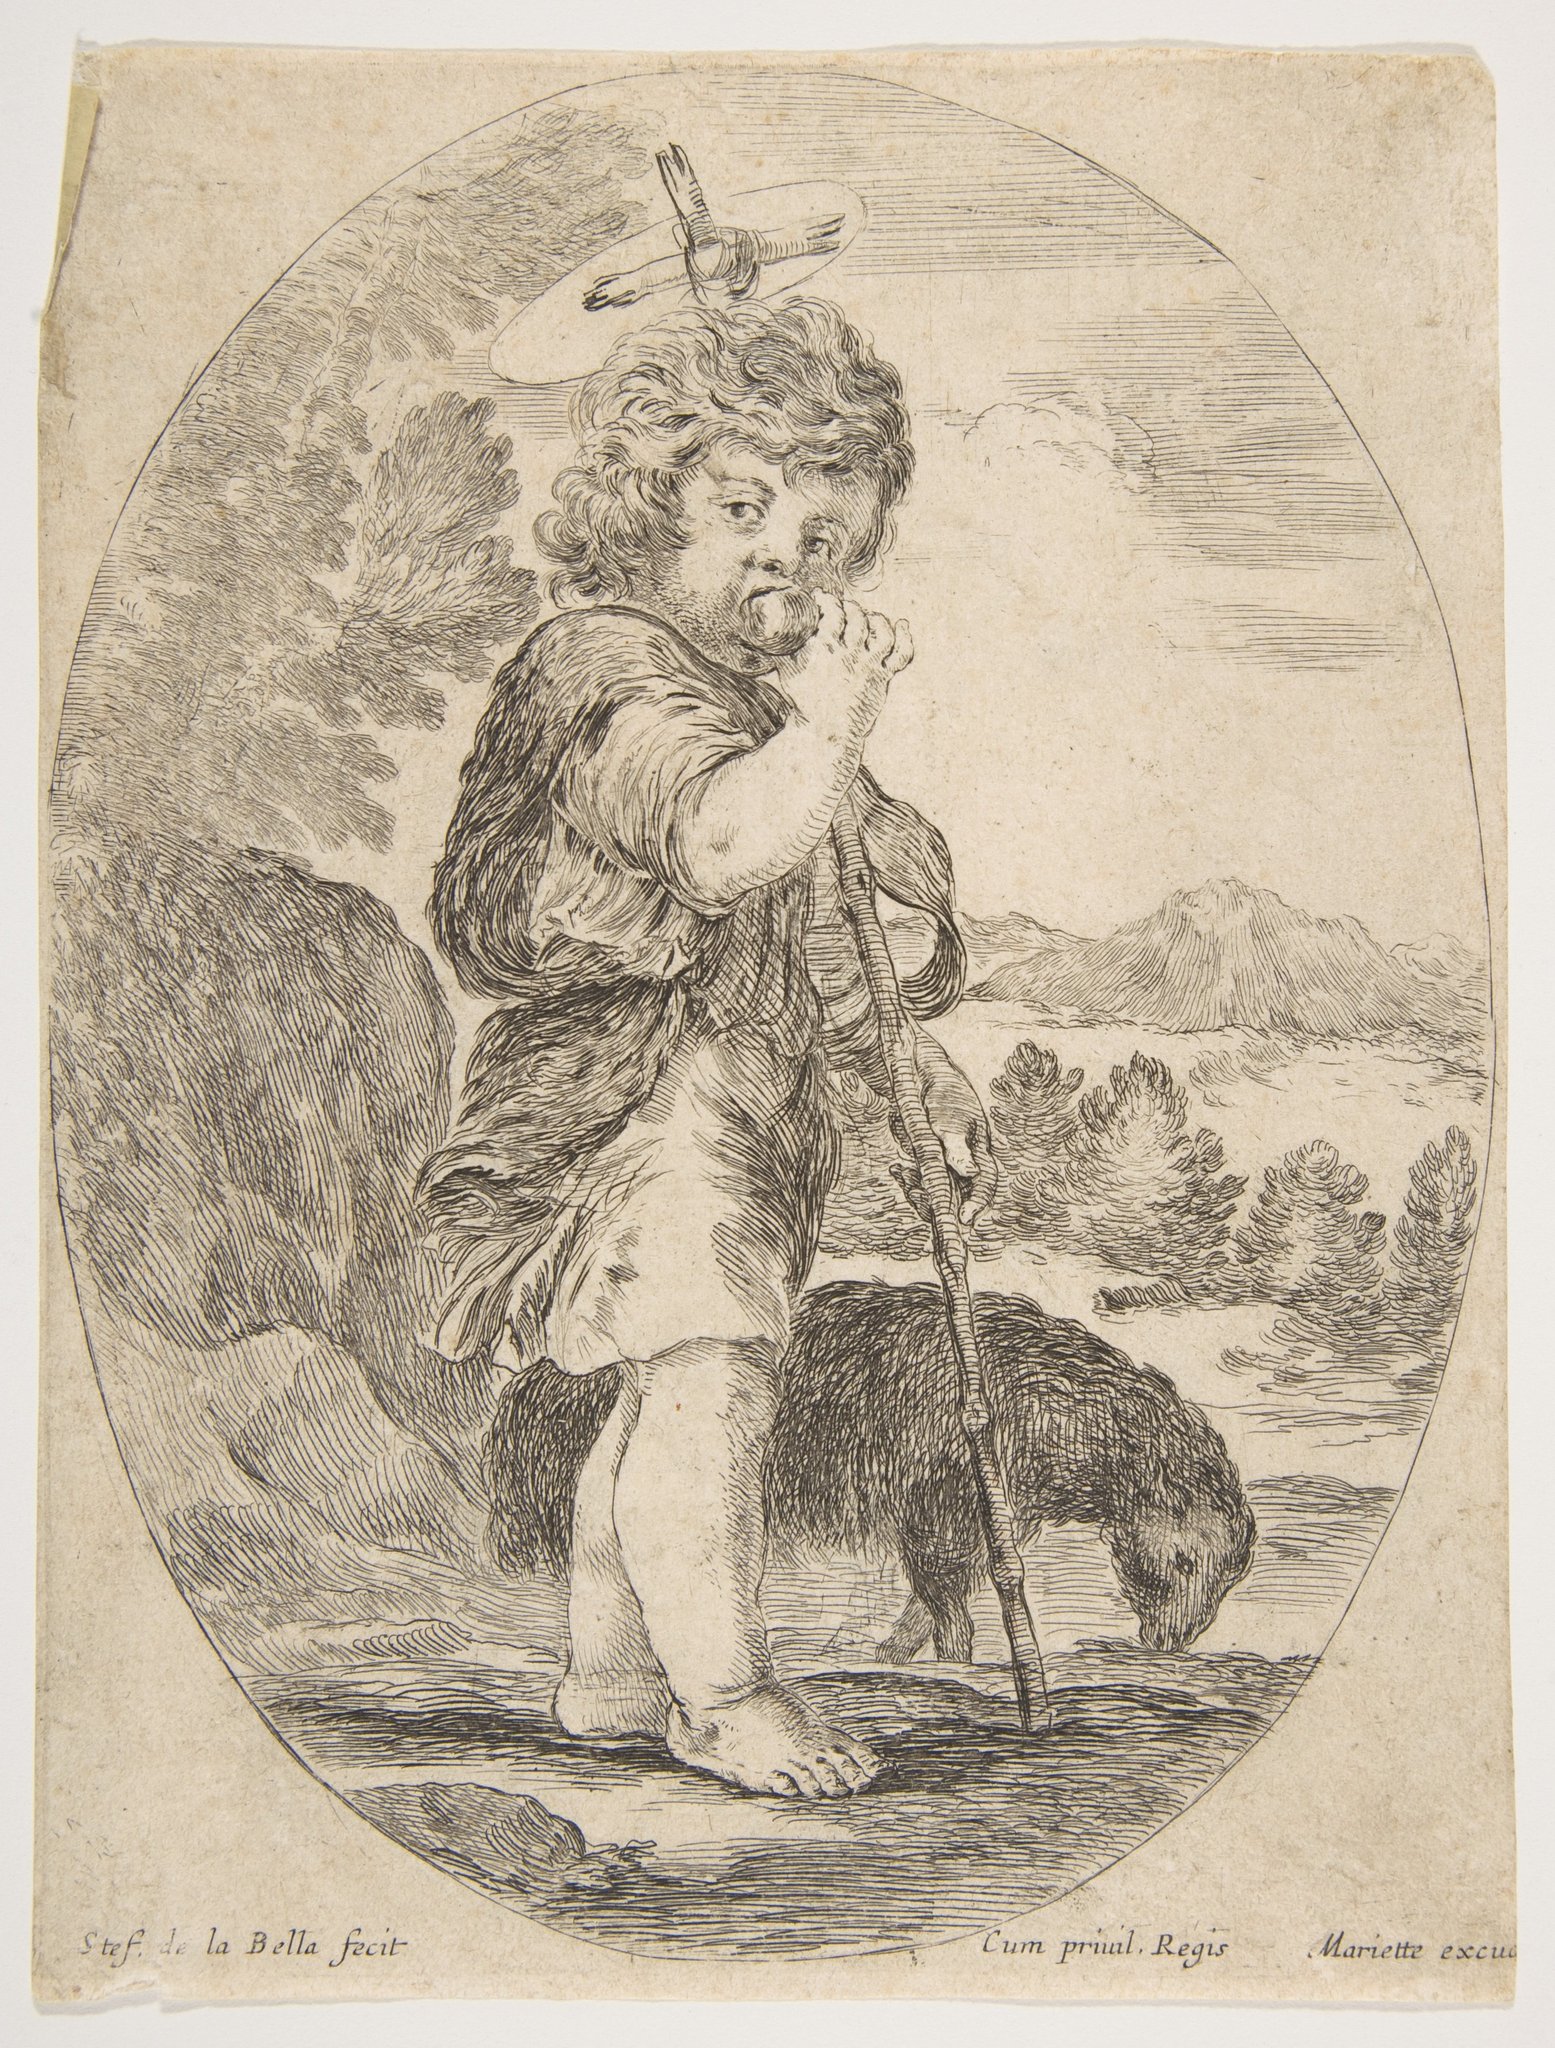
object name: print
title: Saint John the Baptist Biting a Piece of Fruit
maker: stefano della bella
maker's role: artist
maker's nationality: italian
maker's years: 1610-1664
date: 1641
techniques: etching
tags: animals,fruit,saint john the baptist